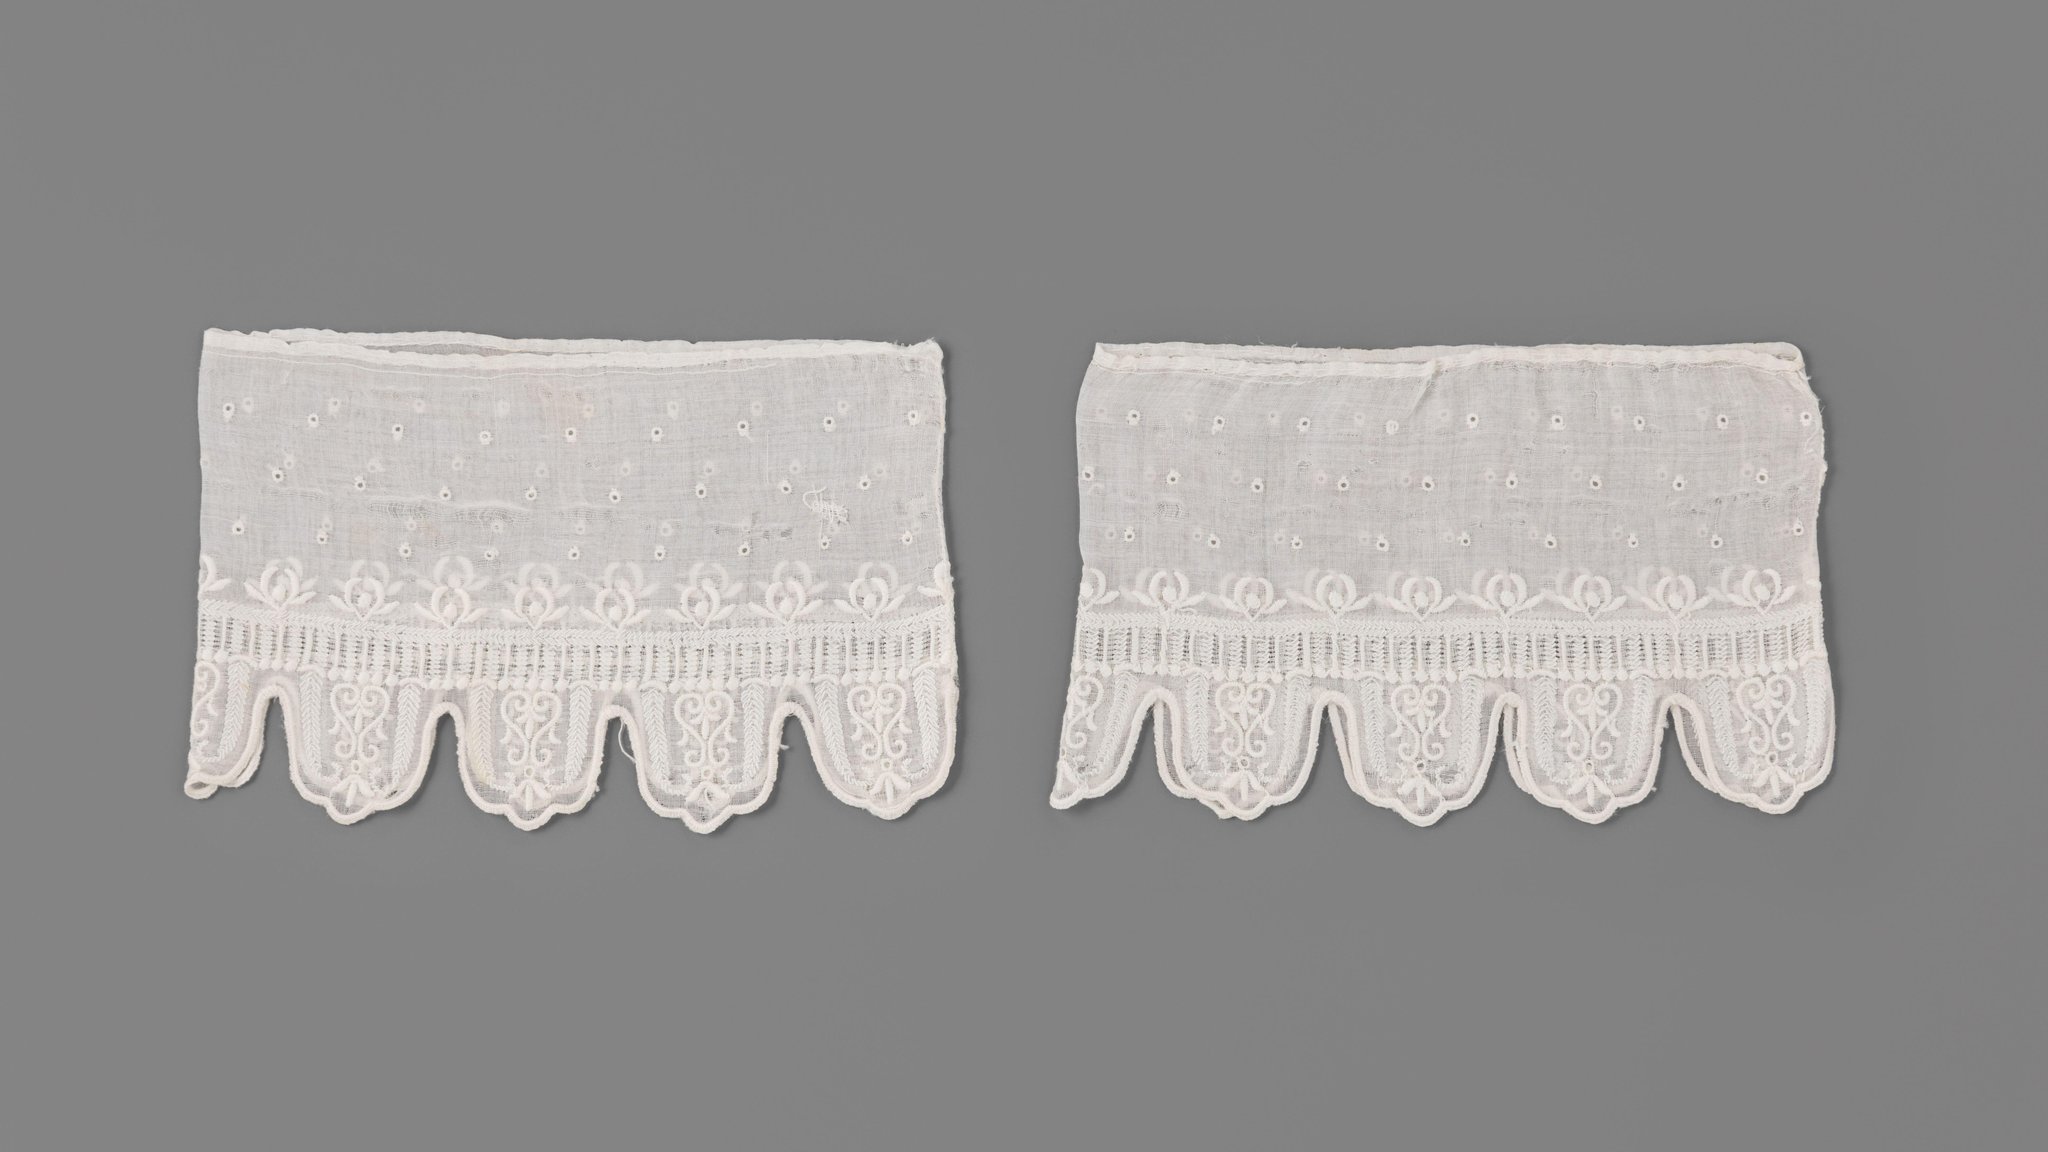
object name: cuff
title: Manchet van batist, versierd met witwerk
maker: Anonymous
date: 1800-1825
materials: textile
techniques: embroidery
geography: western europe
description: Manchetjes van neteldoek met geborduurde schulpen en een Valenciennetje. Model. Korte shawlkraag met oprijgjes. Diepe schulpen. Manchetjes. Cylmtrisch, zonder oprijgjes en kant. Borduurwork. Plumetisborduursel met blaadjesrand en in elke schulp een palmetmotief tussen veertjes.